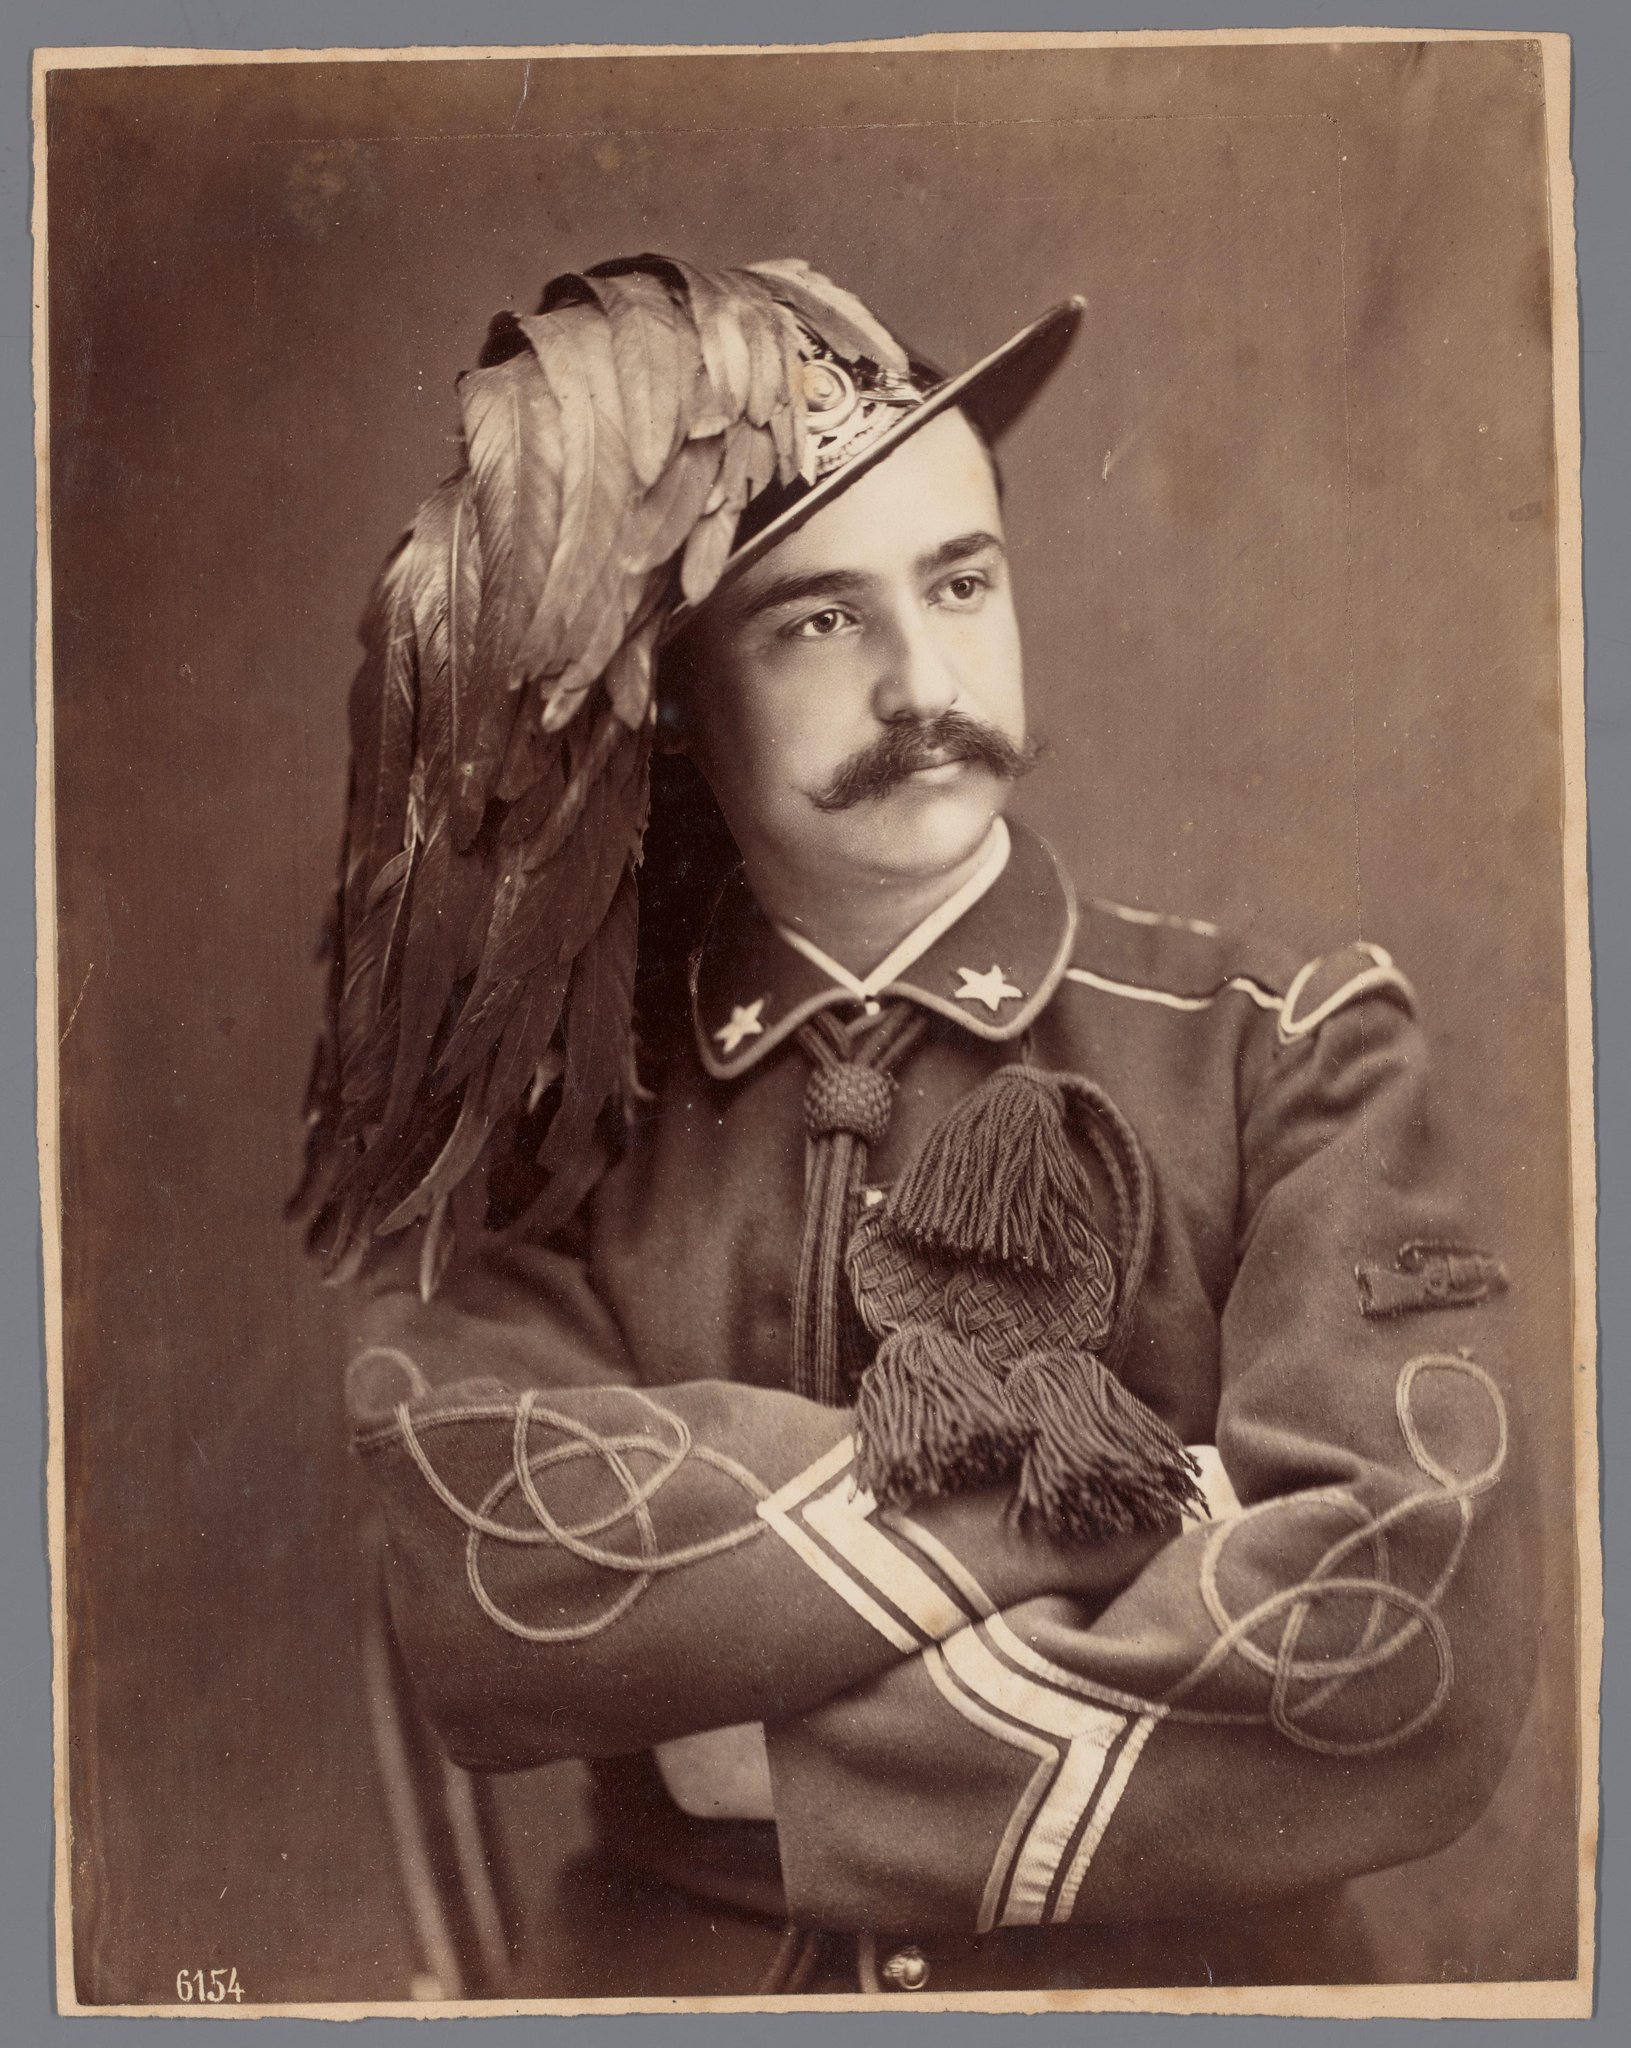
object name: photograph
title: Portret van een onbekende man in uniform en veren op zijn helm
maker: giorgio sommer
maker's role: fotograaf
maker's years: 1834-1914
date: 1857-1914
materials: cardboard, paper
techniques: albumen print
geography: naples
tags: anonymous historical person portrayed, (military) uniforms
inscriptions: number: ‘6154’, inscription: ‘Sommer’